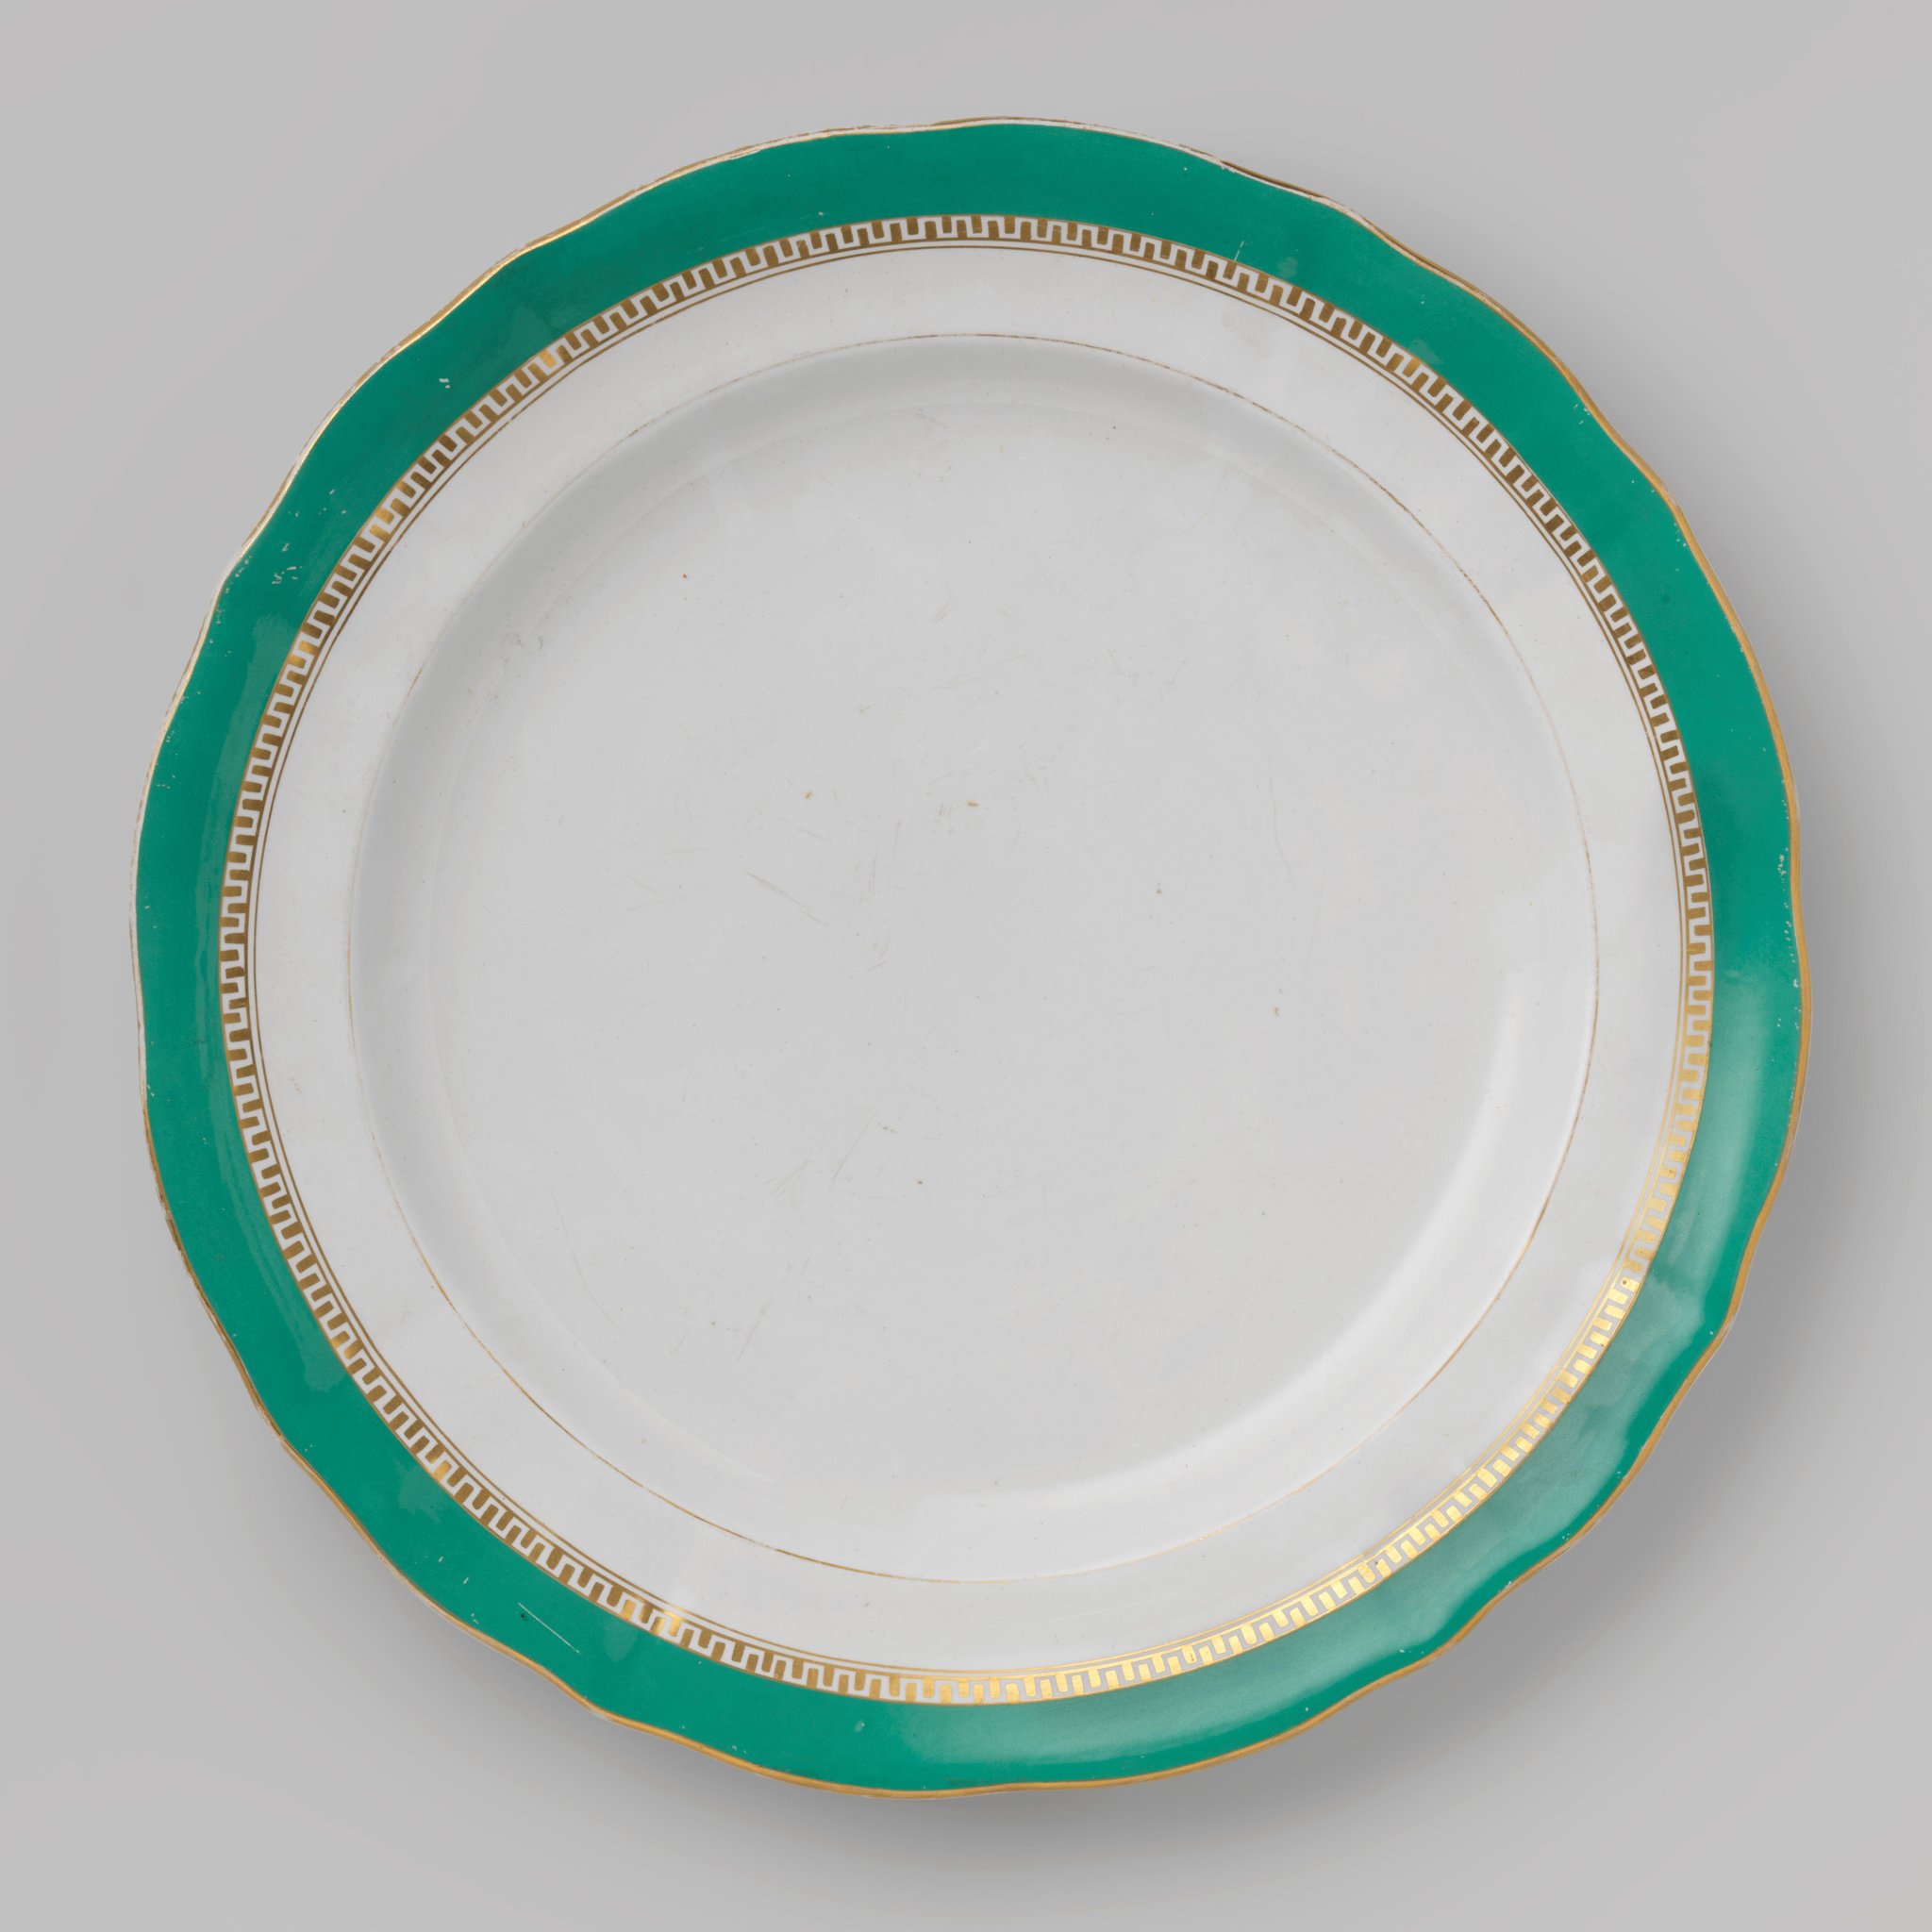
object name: dish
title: Schaal, rond, met groene rand en gouden Griekse band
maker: petrus regout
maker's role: plateelbakker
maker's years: 1801-1879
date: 1865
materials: earthenware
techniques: transfer decoration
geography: maastricht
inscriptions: check stamp: ‘P. REGOUT // 14 // MAASTRICHT’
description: Schaal van aardewerk, rond, geschulpt, met groene rand en gouden Griekse band.